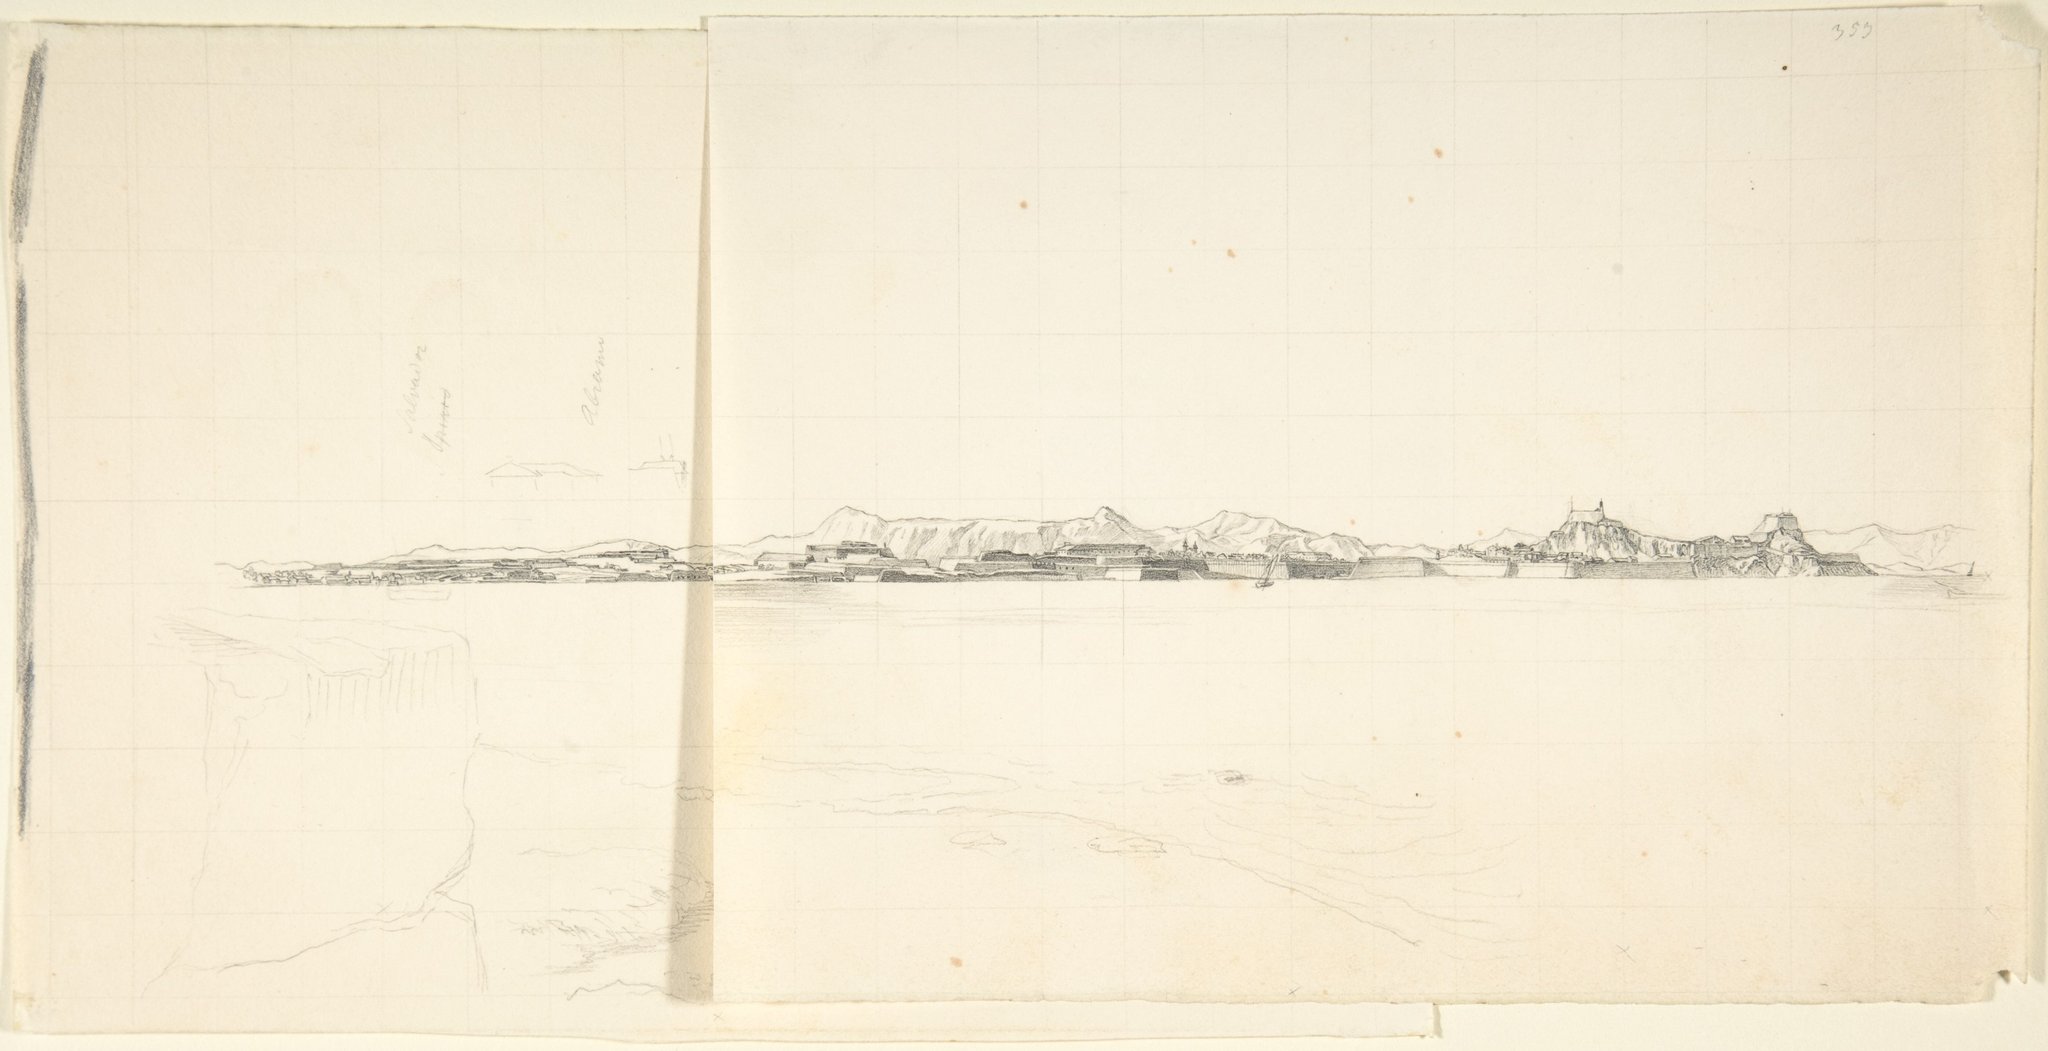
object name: drawing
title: Landscape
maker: franz von hauslab the younger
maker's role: artist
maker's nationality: austrian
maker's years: 1798-1883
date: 1801-1900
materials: pencil, paper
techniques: drawing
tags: houses,mountains,landscapes